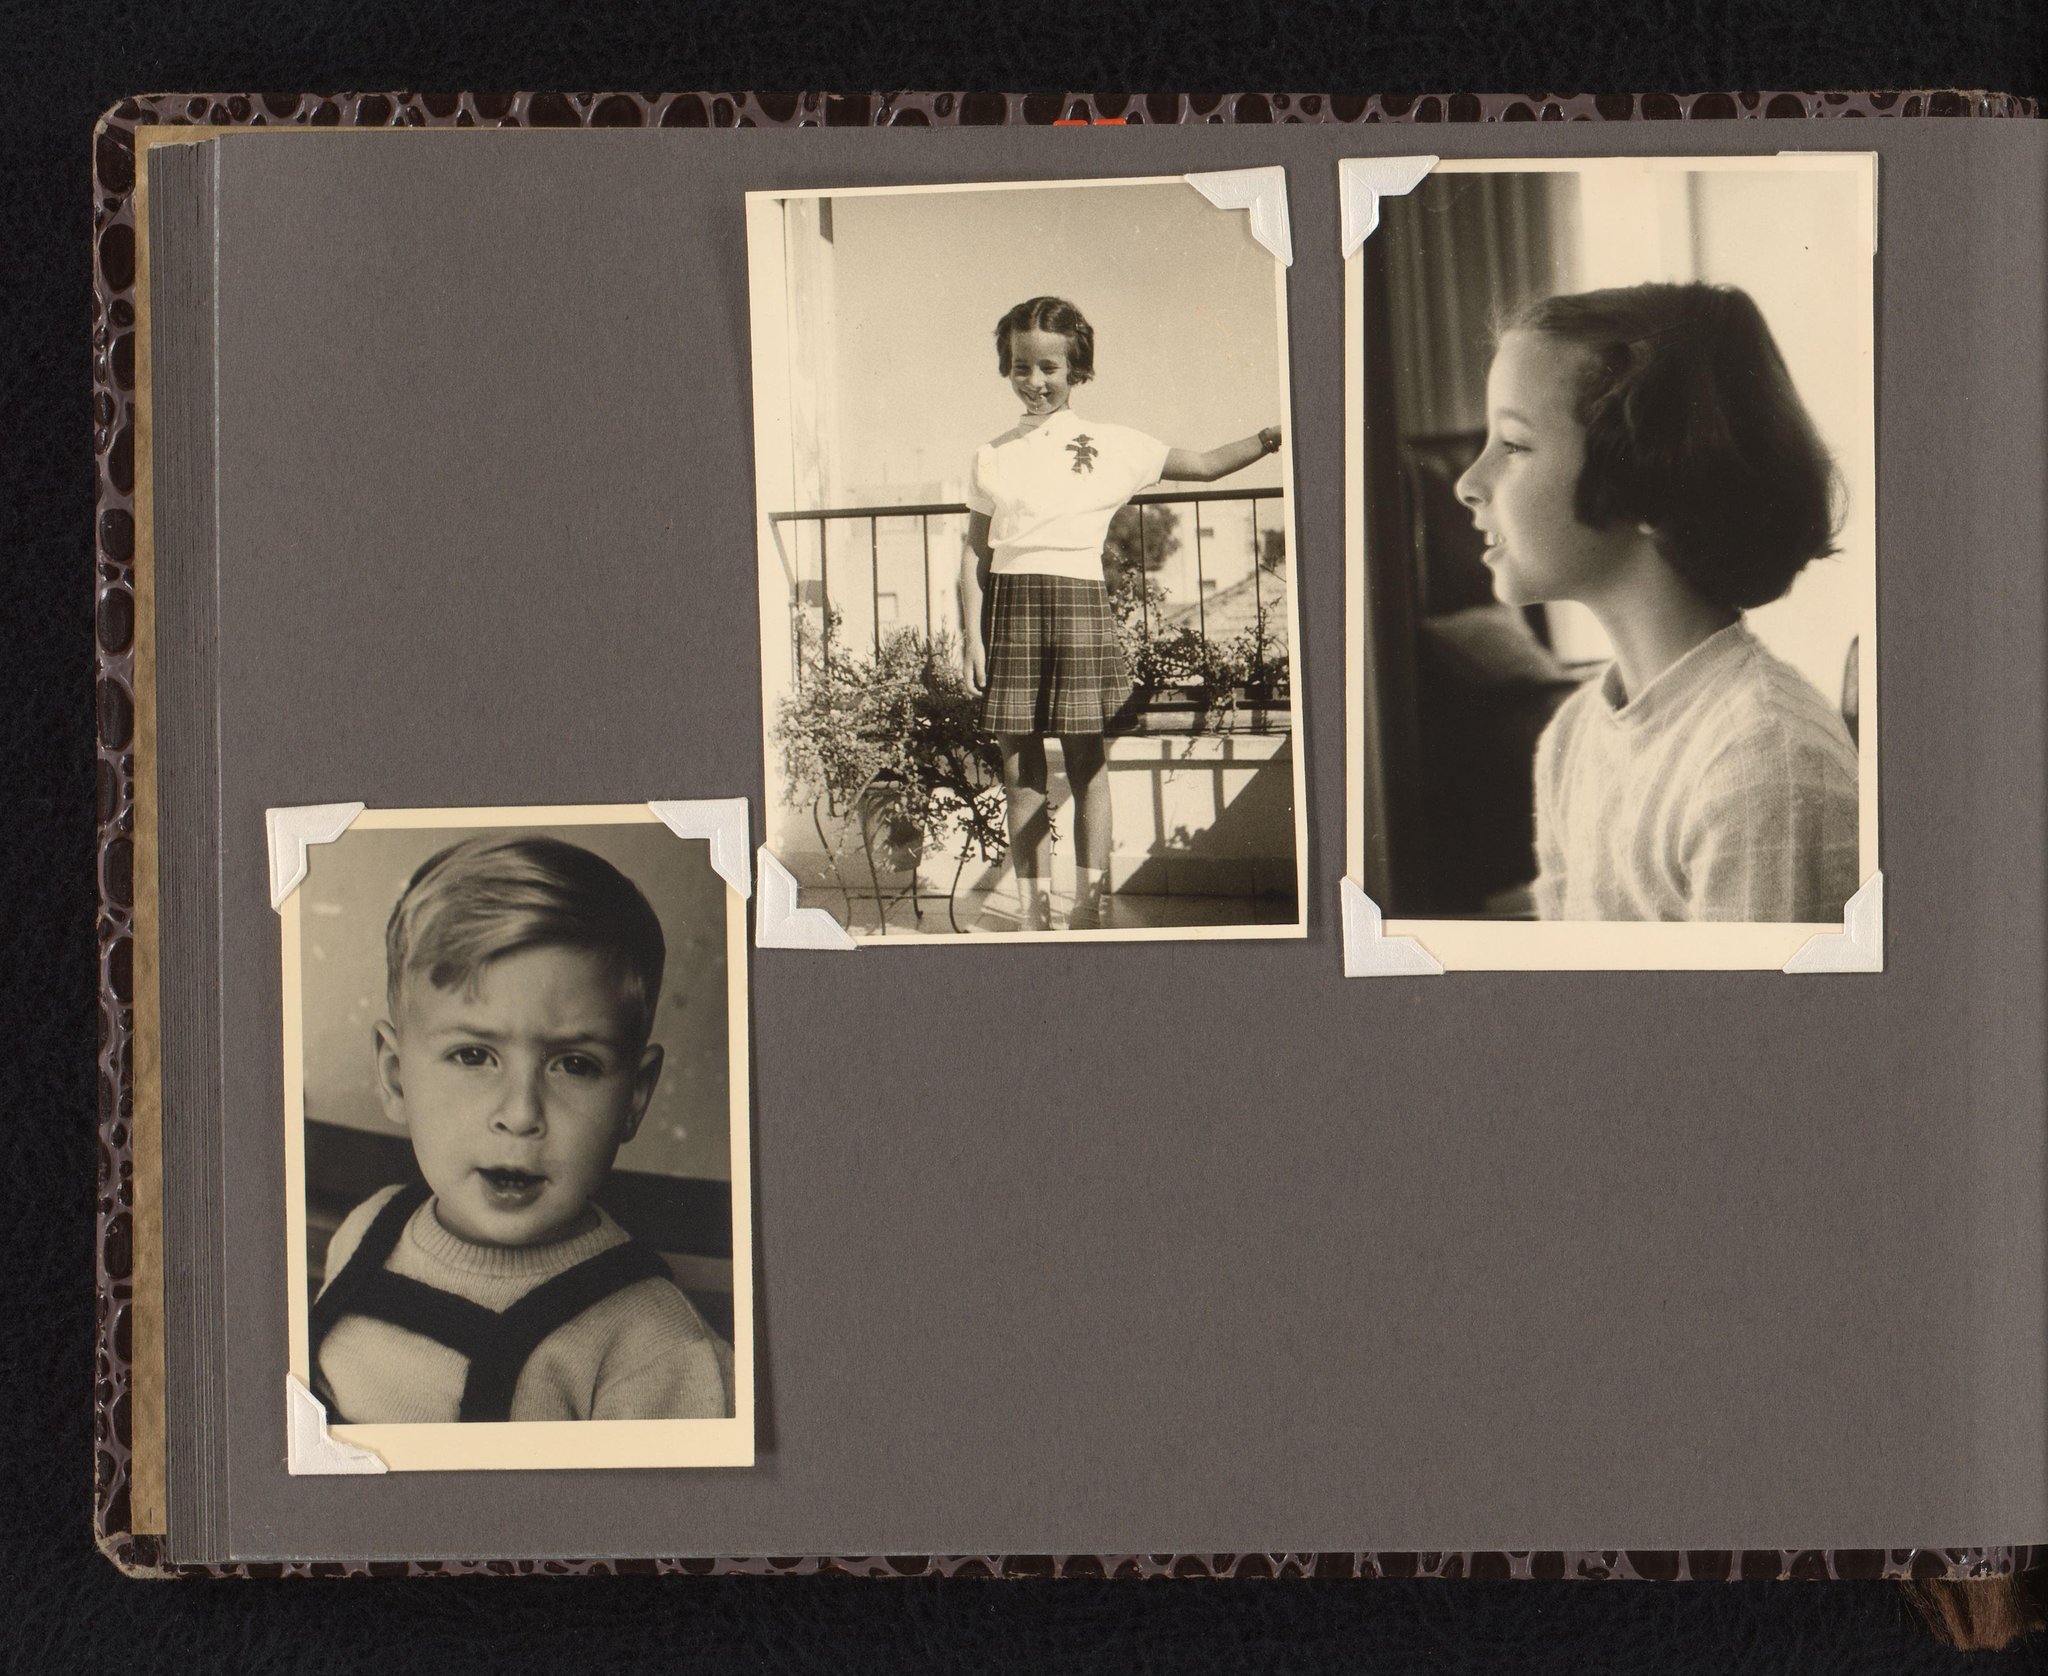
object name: photograph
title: Kinderen, waarschijnlijk kinderen van persoonlijke bekenden van Isabel Wachenheimer, 1947-1955?, Israël/Verenigde Staten?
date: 1947-1955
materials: cardboard, photographic support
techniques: gelatin silver print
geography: ramat-gan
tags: historical persons - bb - woman, historical persons not known by name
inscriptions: inscription, name: ‘A. Hatanson 17 Hakeshet St. Ramat Gan’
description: Blad bevat drie foto's van een vriendin (Raja Seligmann) en een onbekende jongen. Uit album half formaat, kunstlederen omslag met koordbinding.